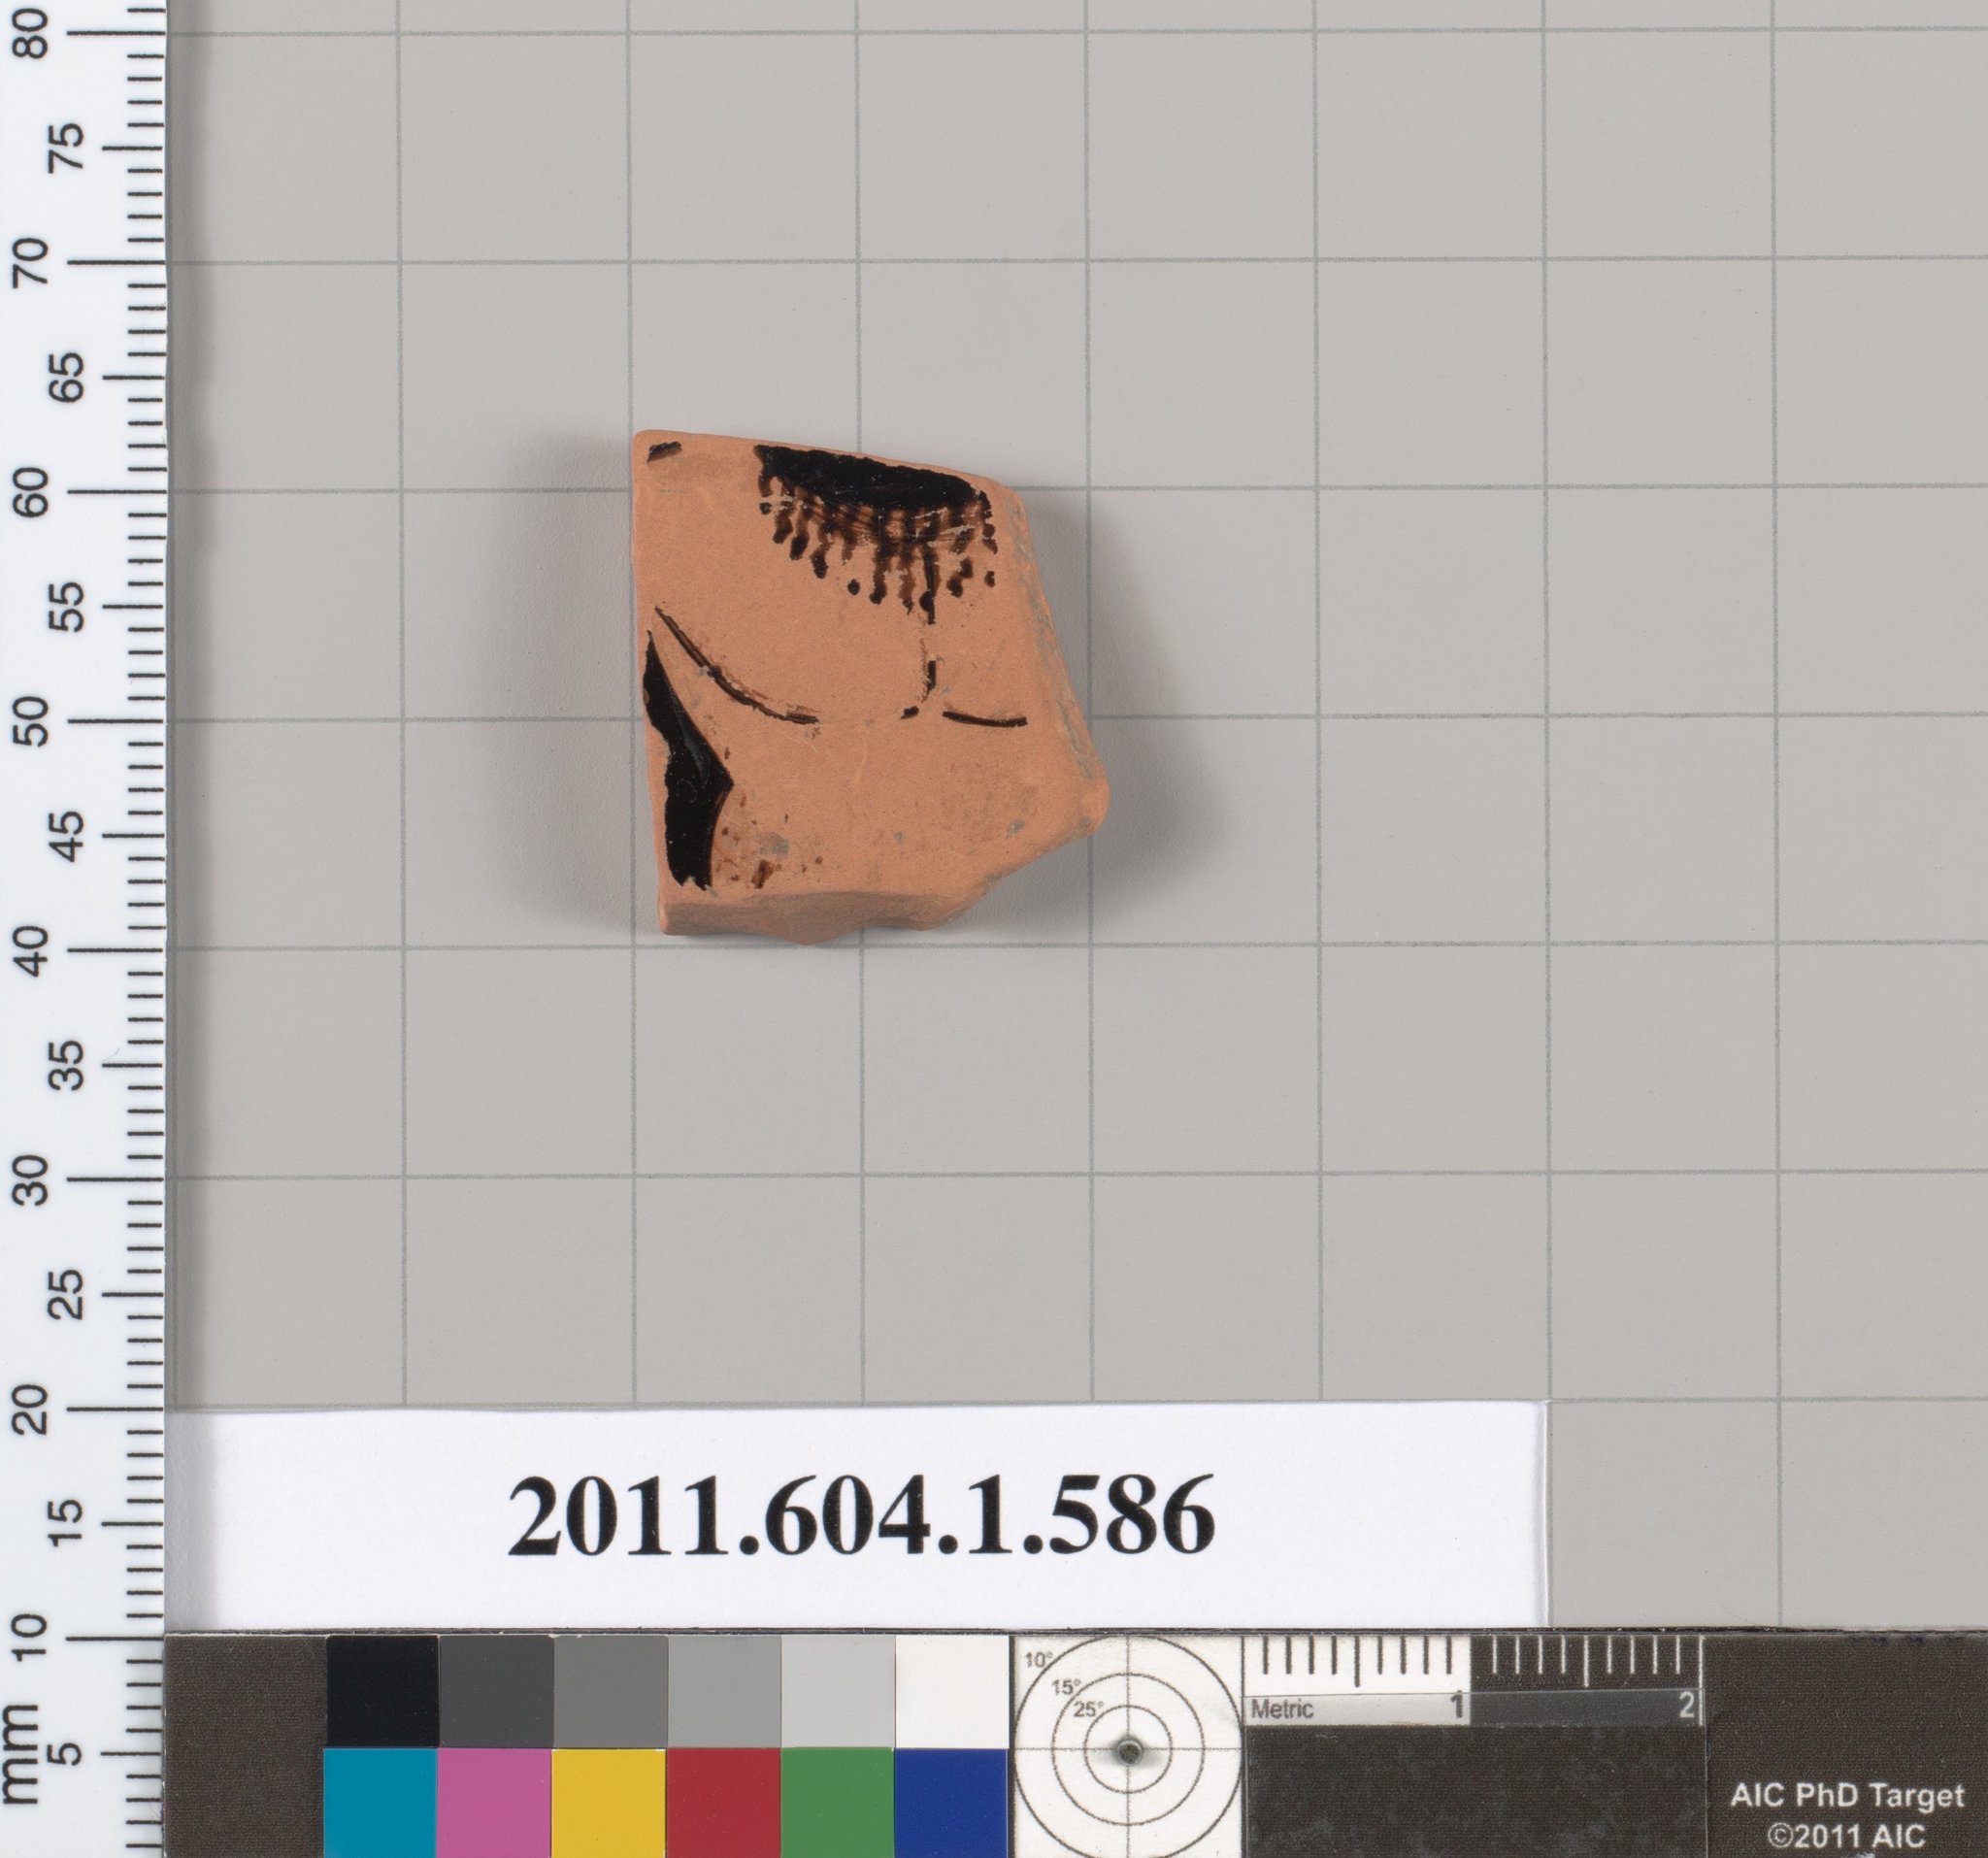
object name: kylix fragment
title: Terracotta fragment of a kylix (drinking cup)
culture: greek, attic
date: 475-451 BCE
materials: terracotta